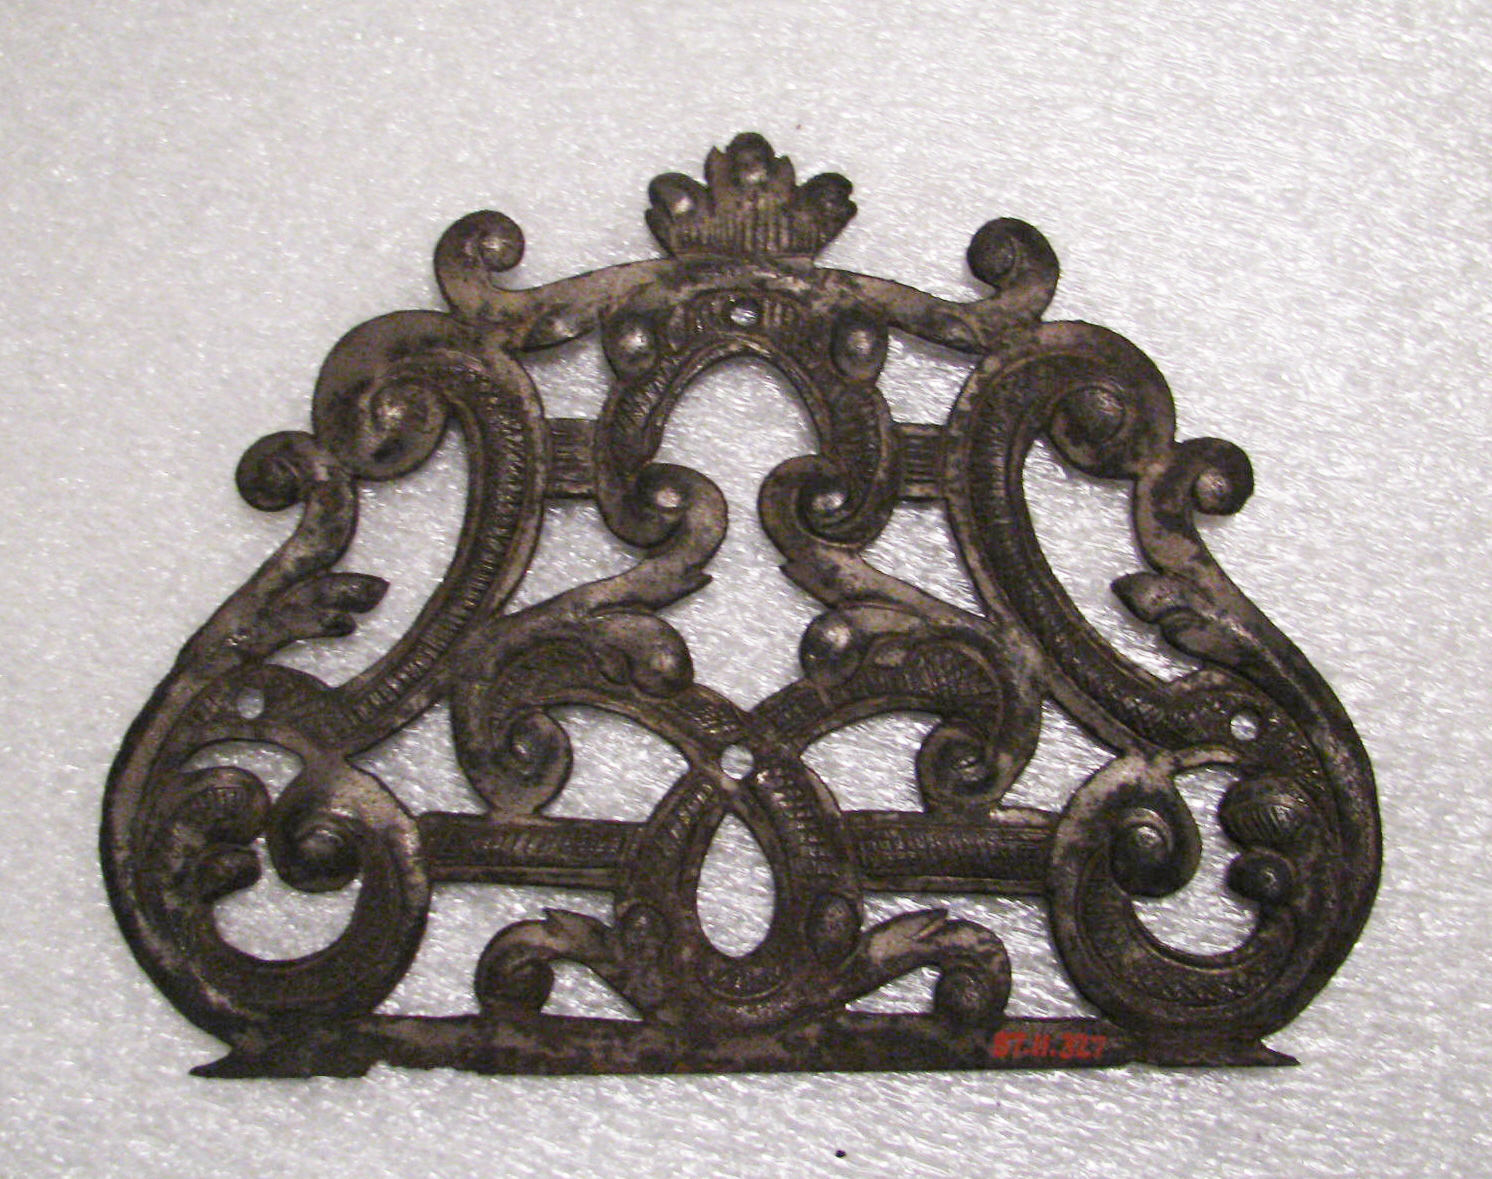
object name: plaque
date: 1700-1740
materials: iron